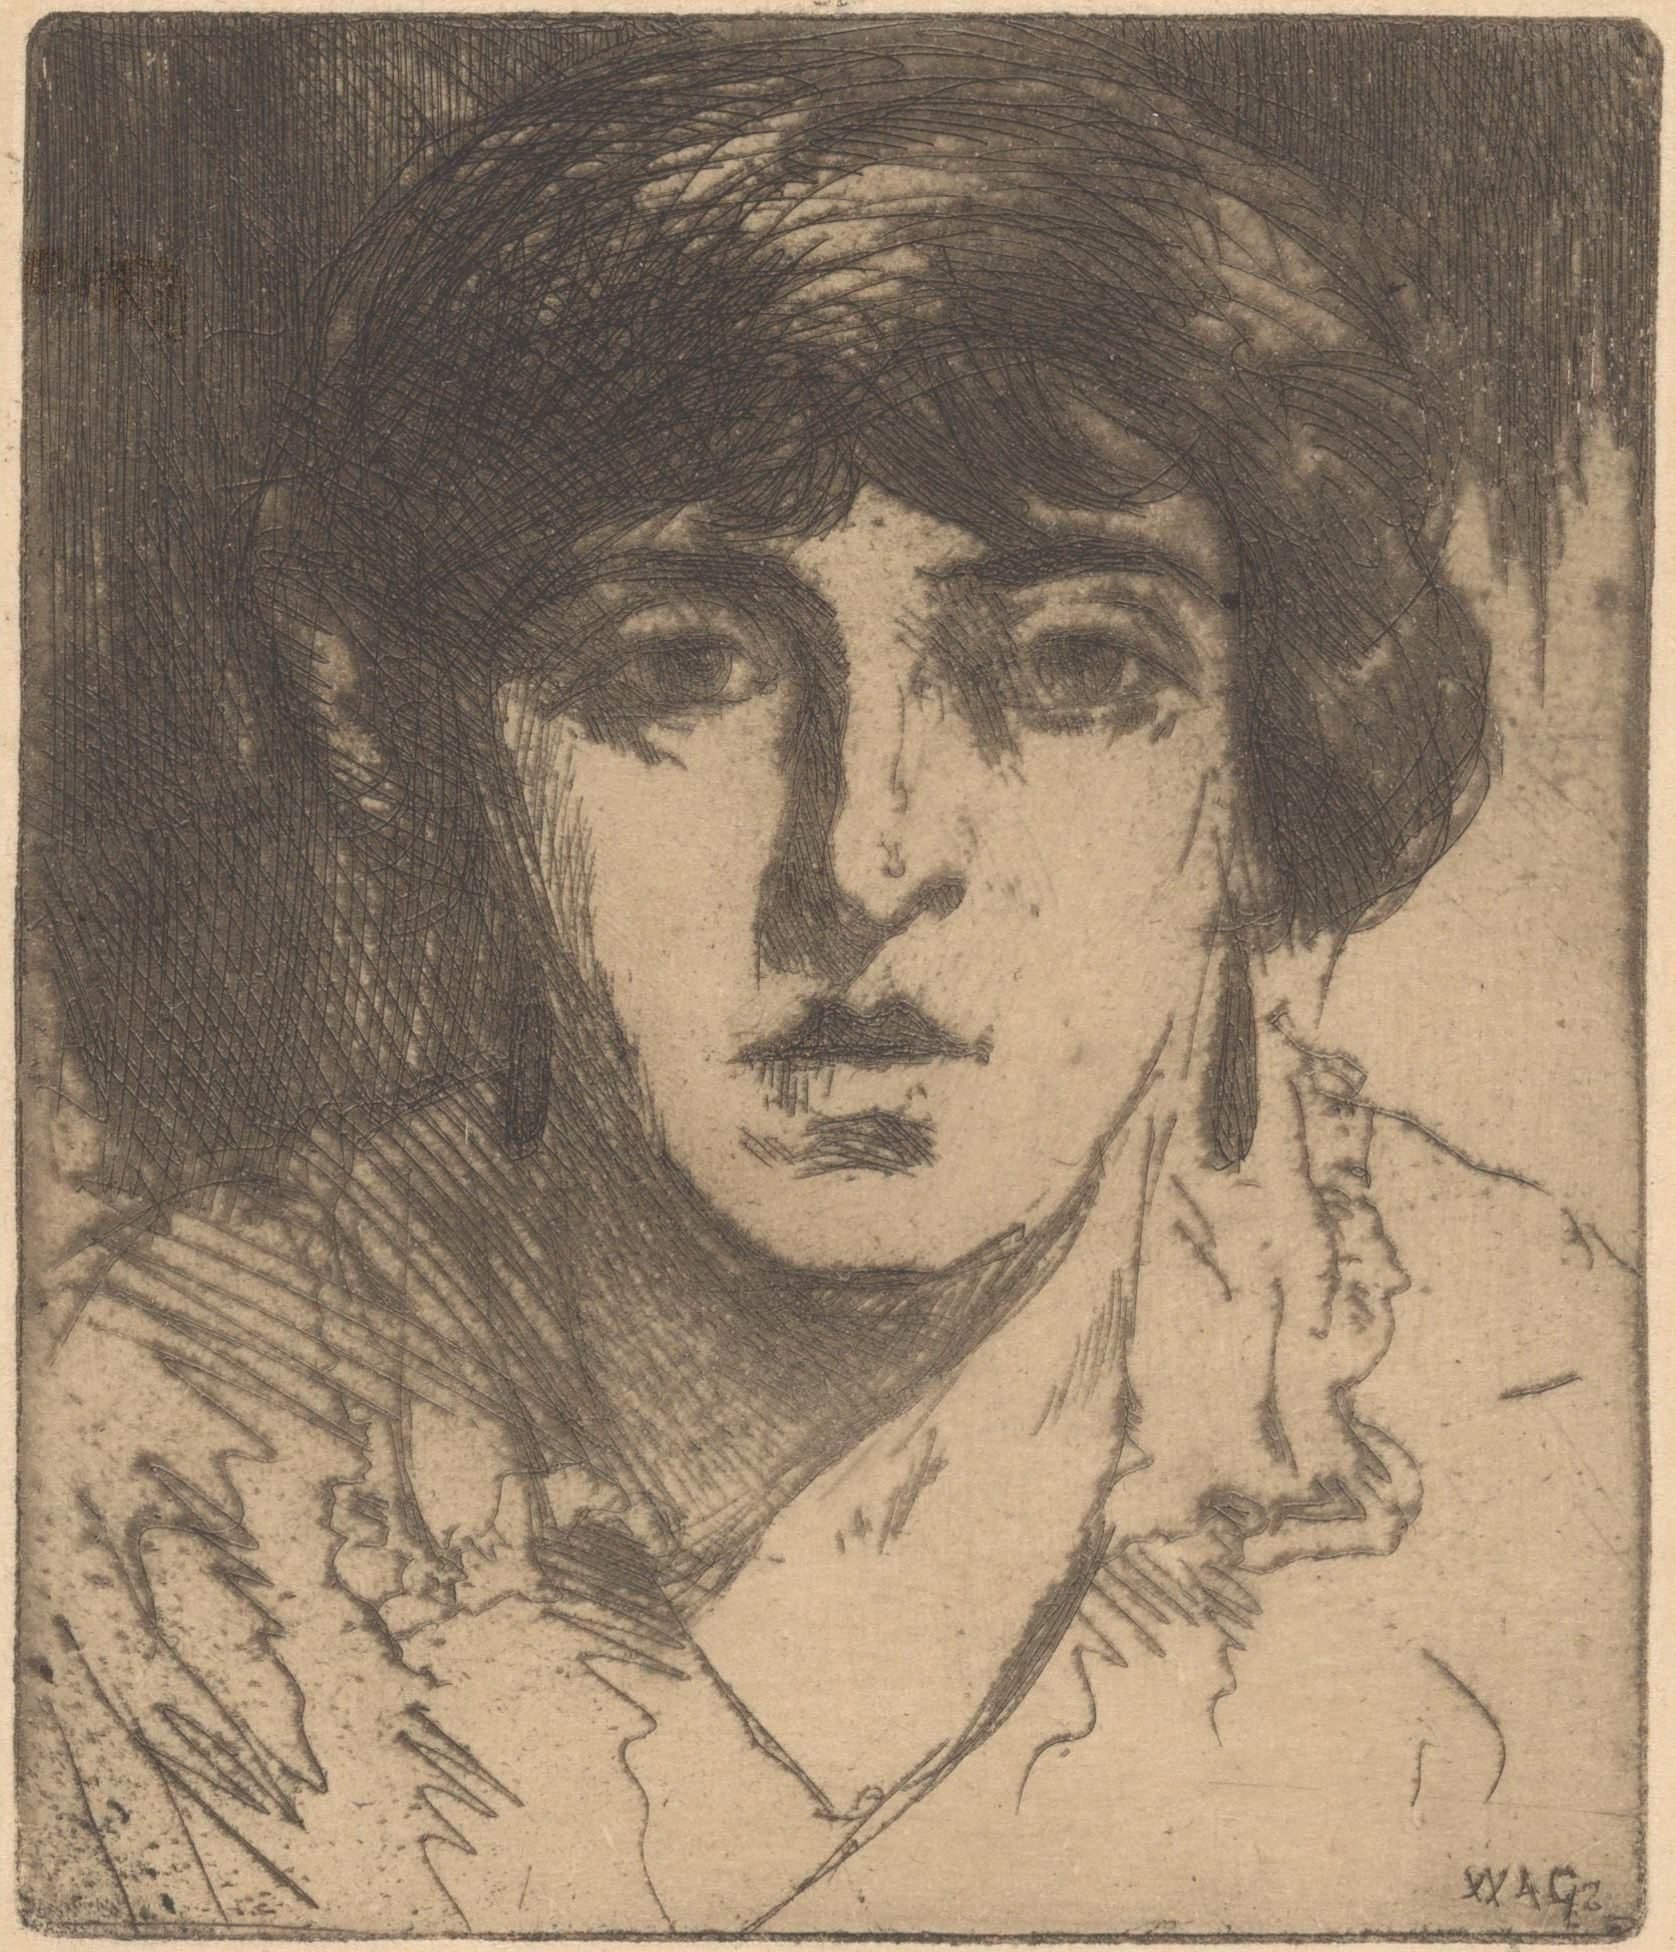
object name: print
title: Portret van een onbekende vrouw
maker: willem adrianus grondhout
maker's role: draughtsman, painter, print maker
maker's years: 1878-1934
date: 1888-1934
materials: paper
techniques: etching, intaglio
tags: anonymous historical person portrayed - bb - woman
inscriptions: collector's mark: Lugt 2228, number: ‘1’